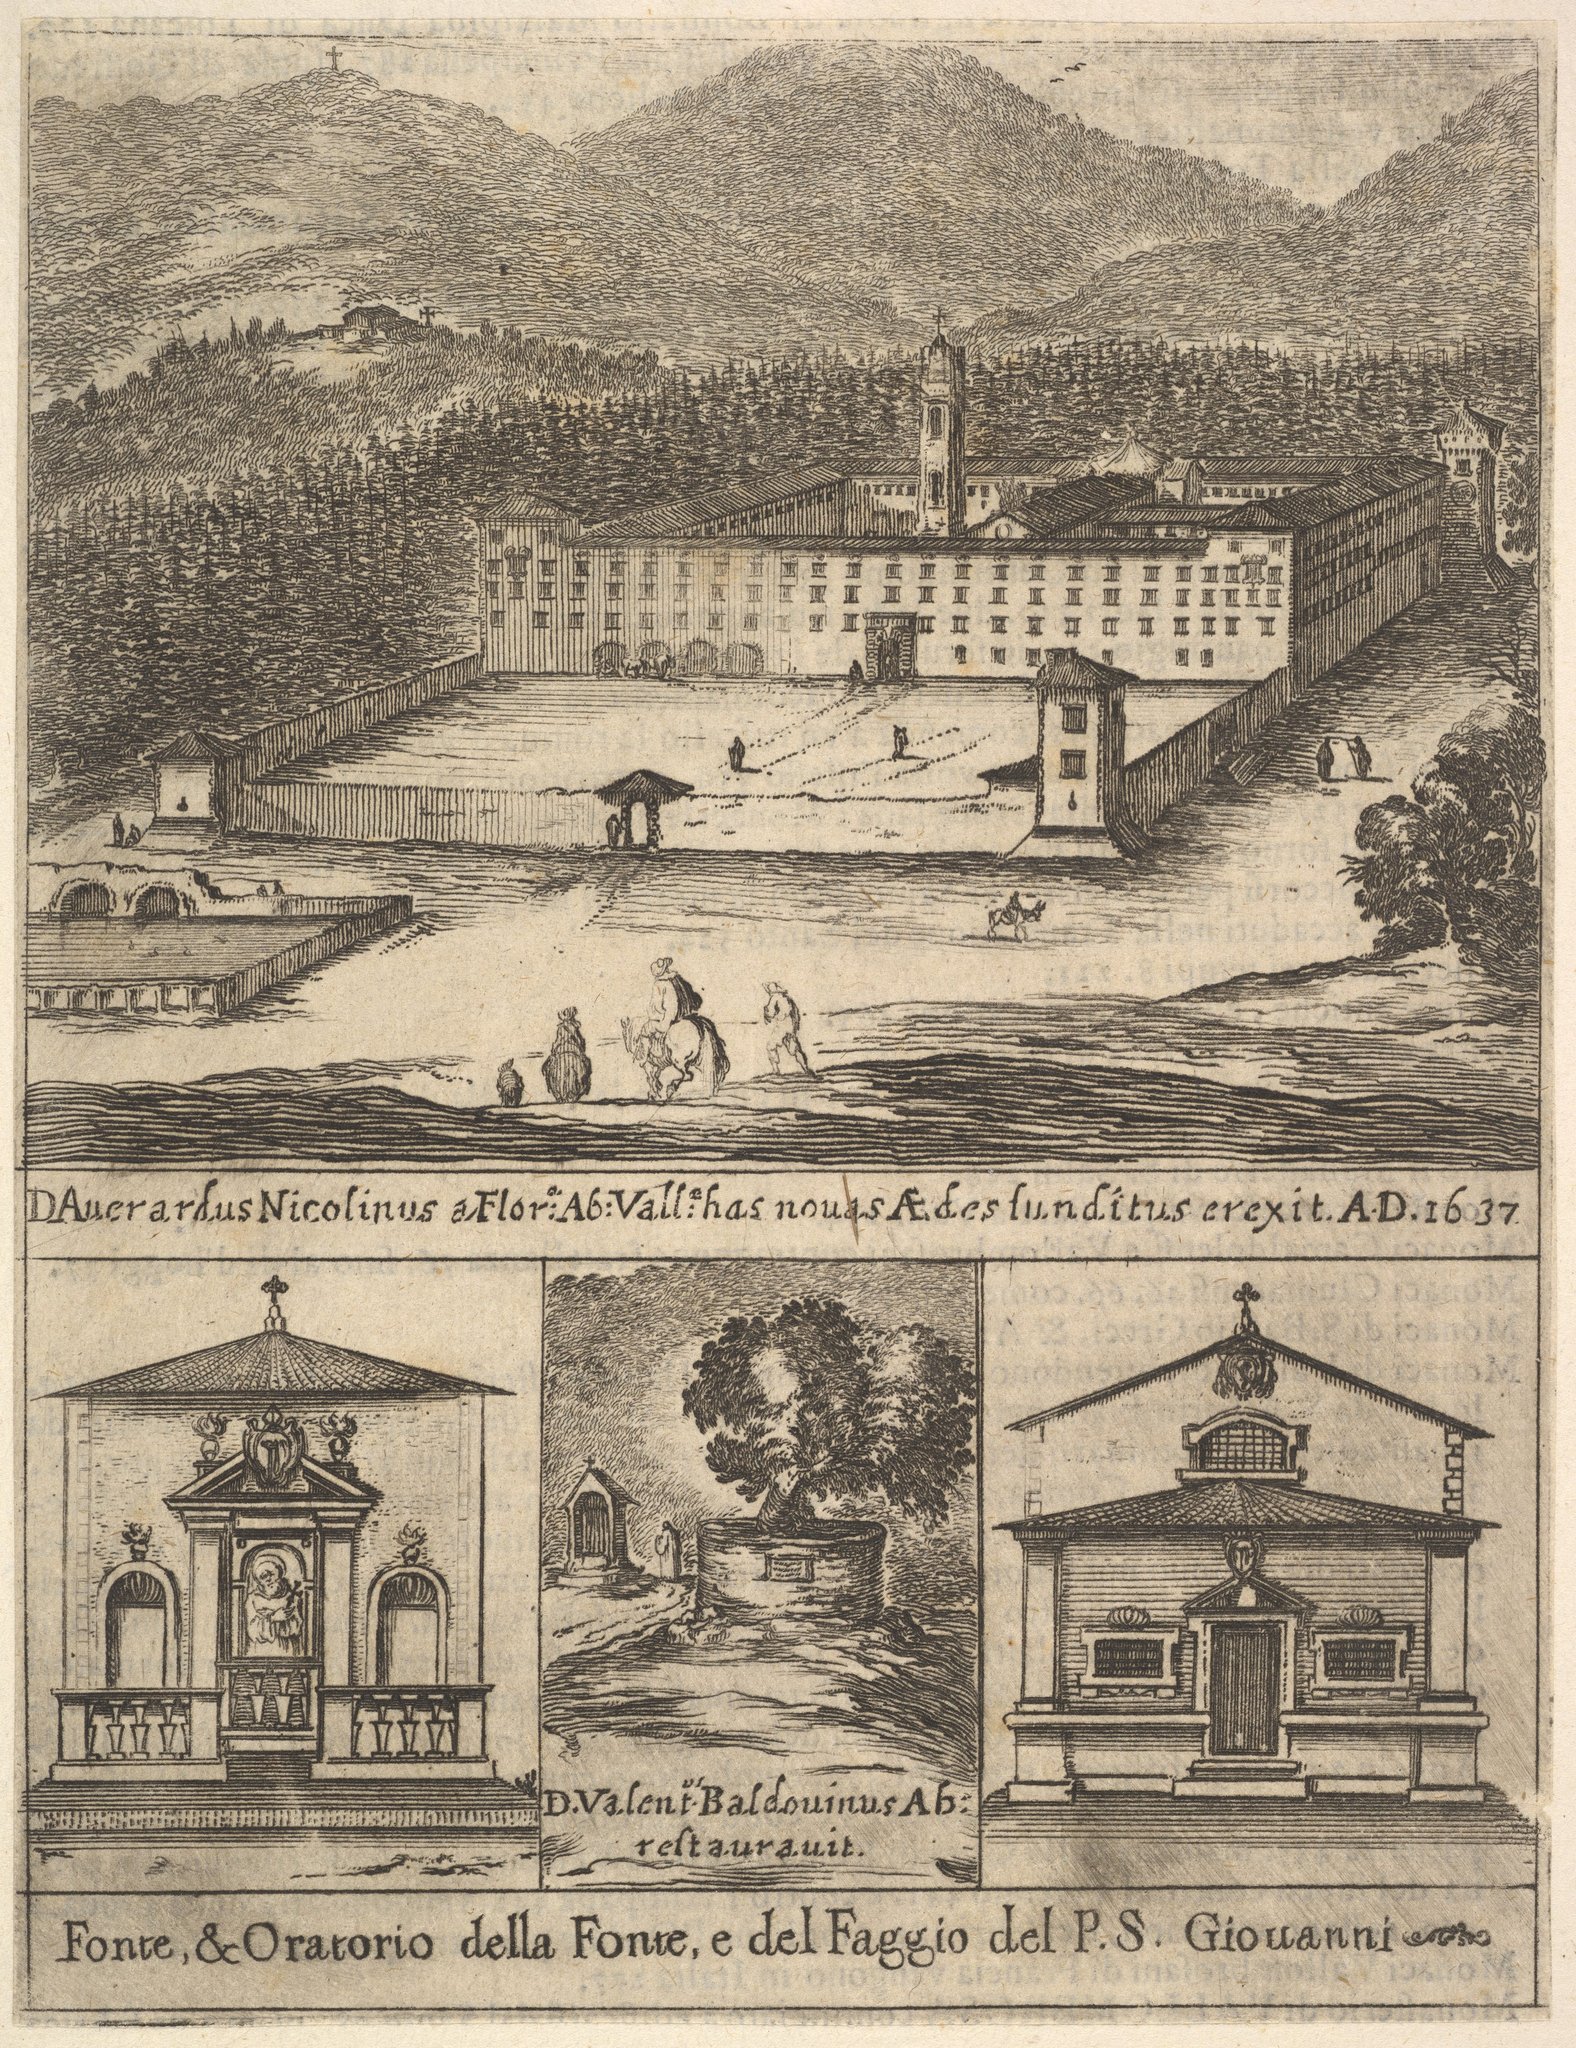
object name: print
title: Four views: at top, a view of the new monastery of Vallombrosa, at bottom left and right, a view of a chapel, at bottom center, the tree of St. John Gualbert, from "Frontispiece and four scenes from the life of Saint John Gualbert" (Frontispice et quatre vignettes pour une vie de Saint Jean Gualbert)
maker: stefano della bella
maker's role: artist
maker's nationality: italian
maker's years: 1610-1664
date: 1640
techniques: etching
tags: buildings,men,trees